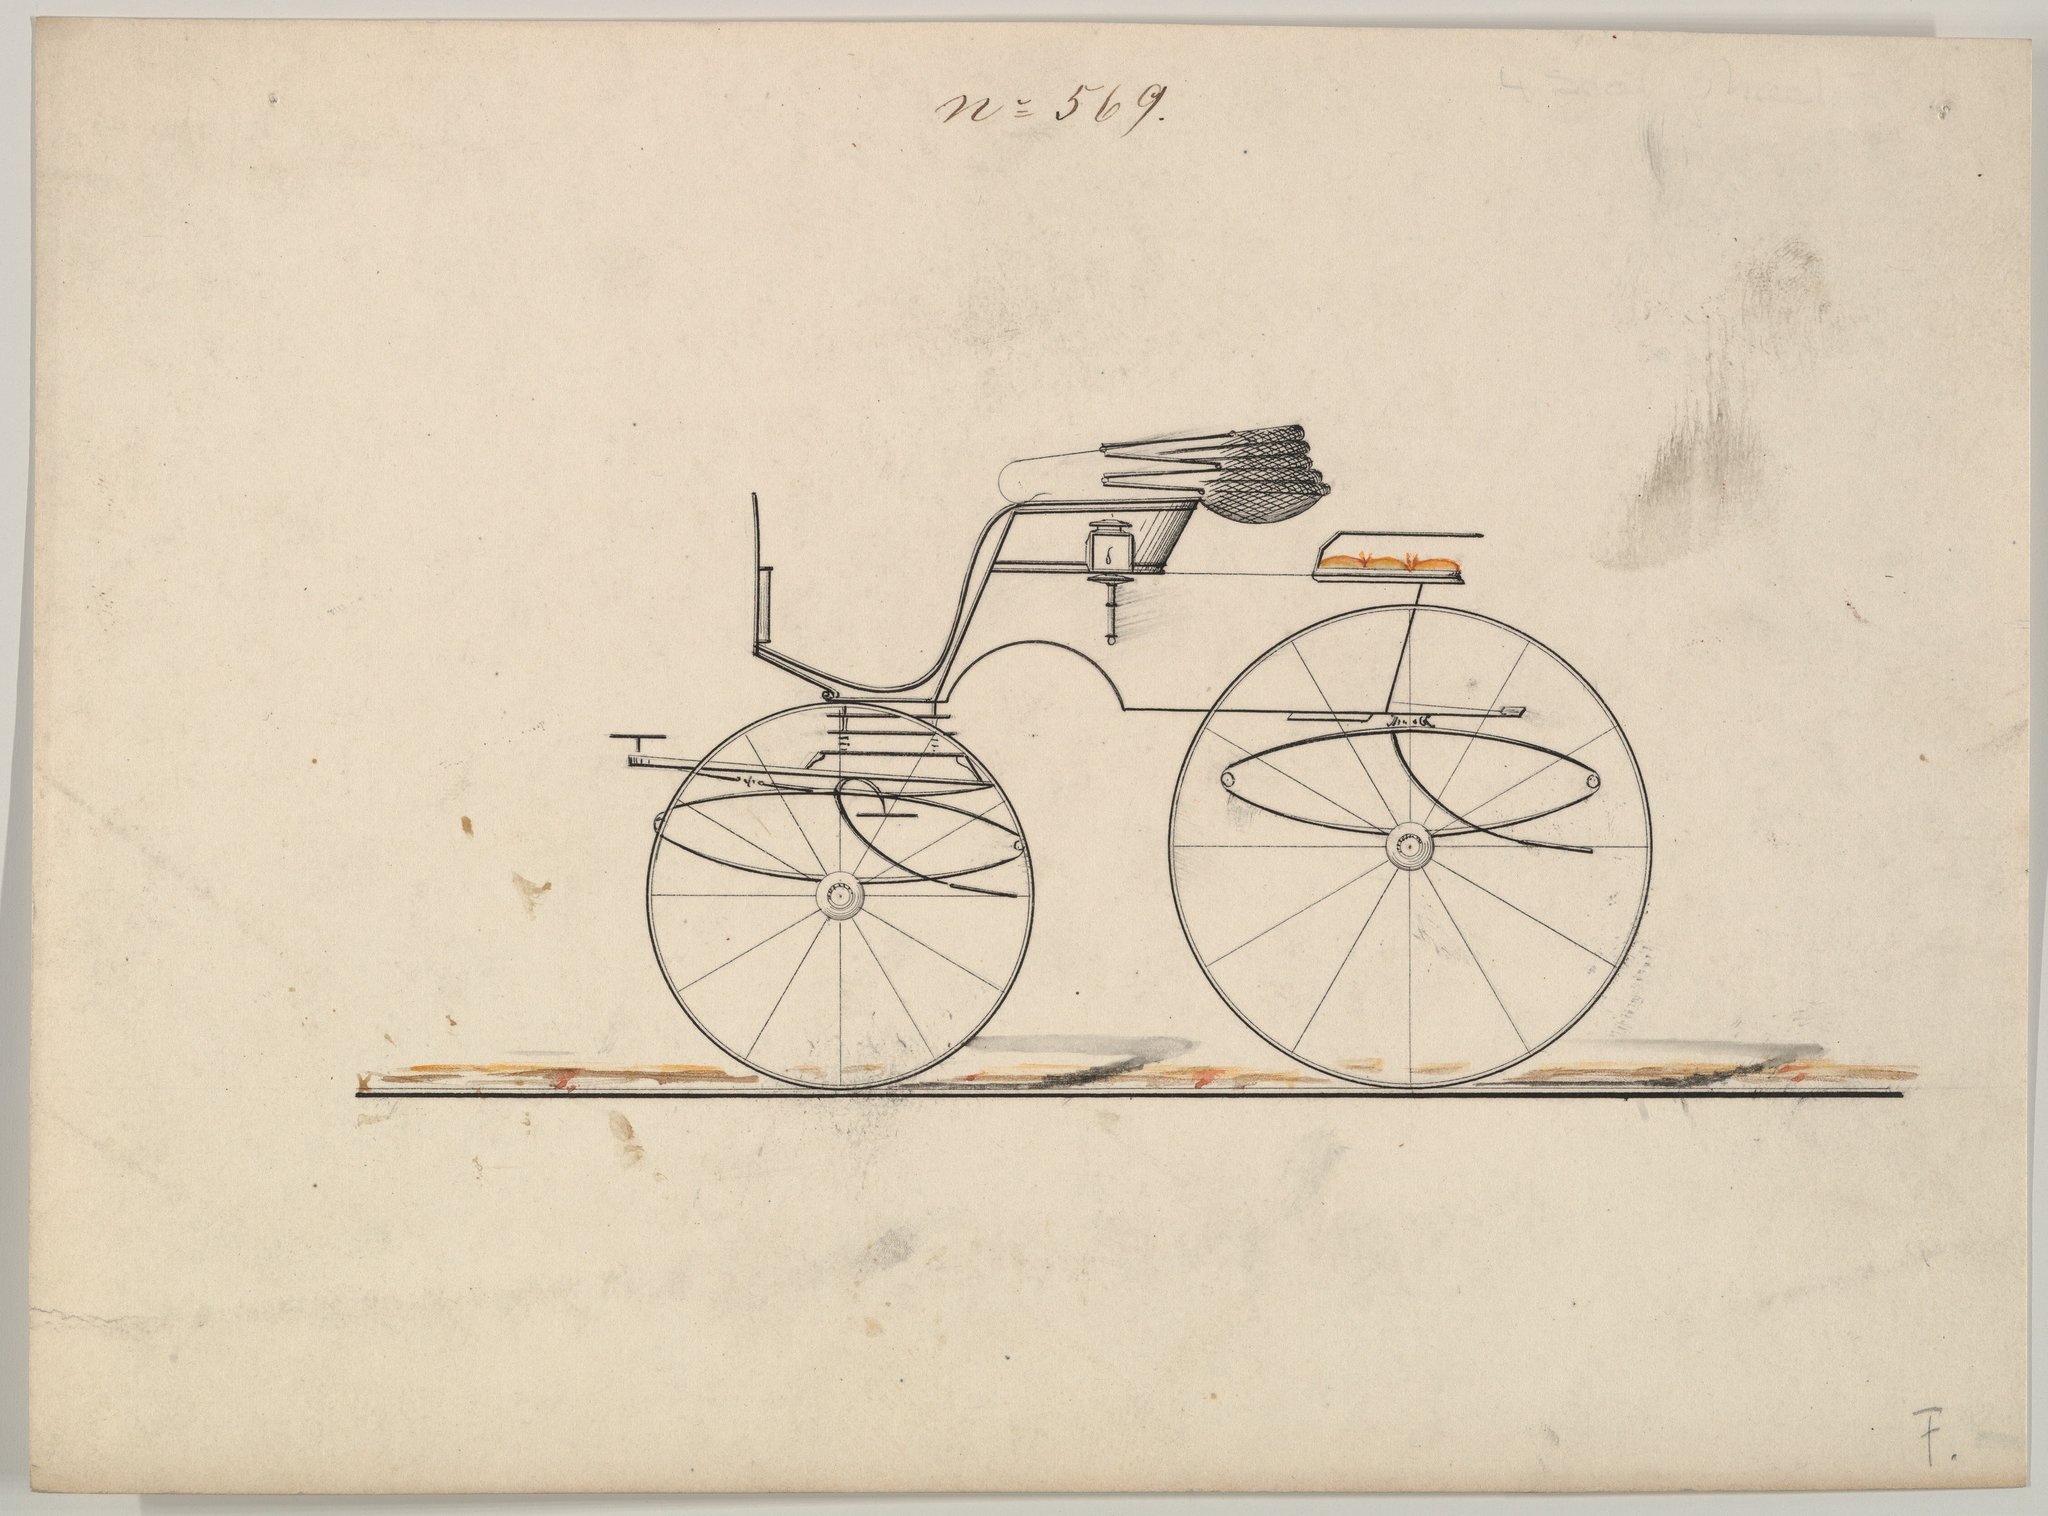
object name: drawing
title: Design for Stanhope Phaeton, no. 569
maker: brewster & co.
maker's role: manufacturer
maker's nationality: american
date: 1850-1874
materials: gouache, ink, watercolor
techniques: pen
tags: carriages